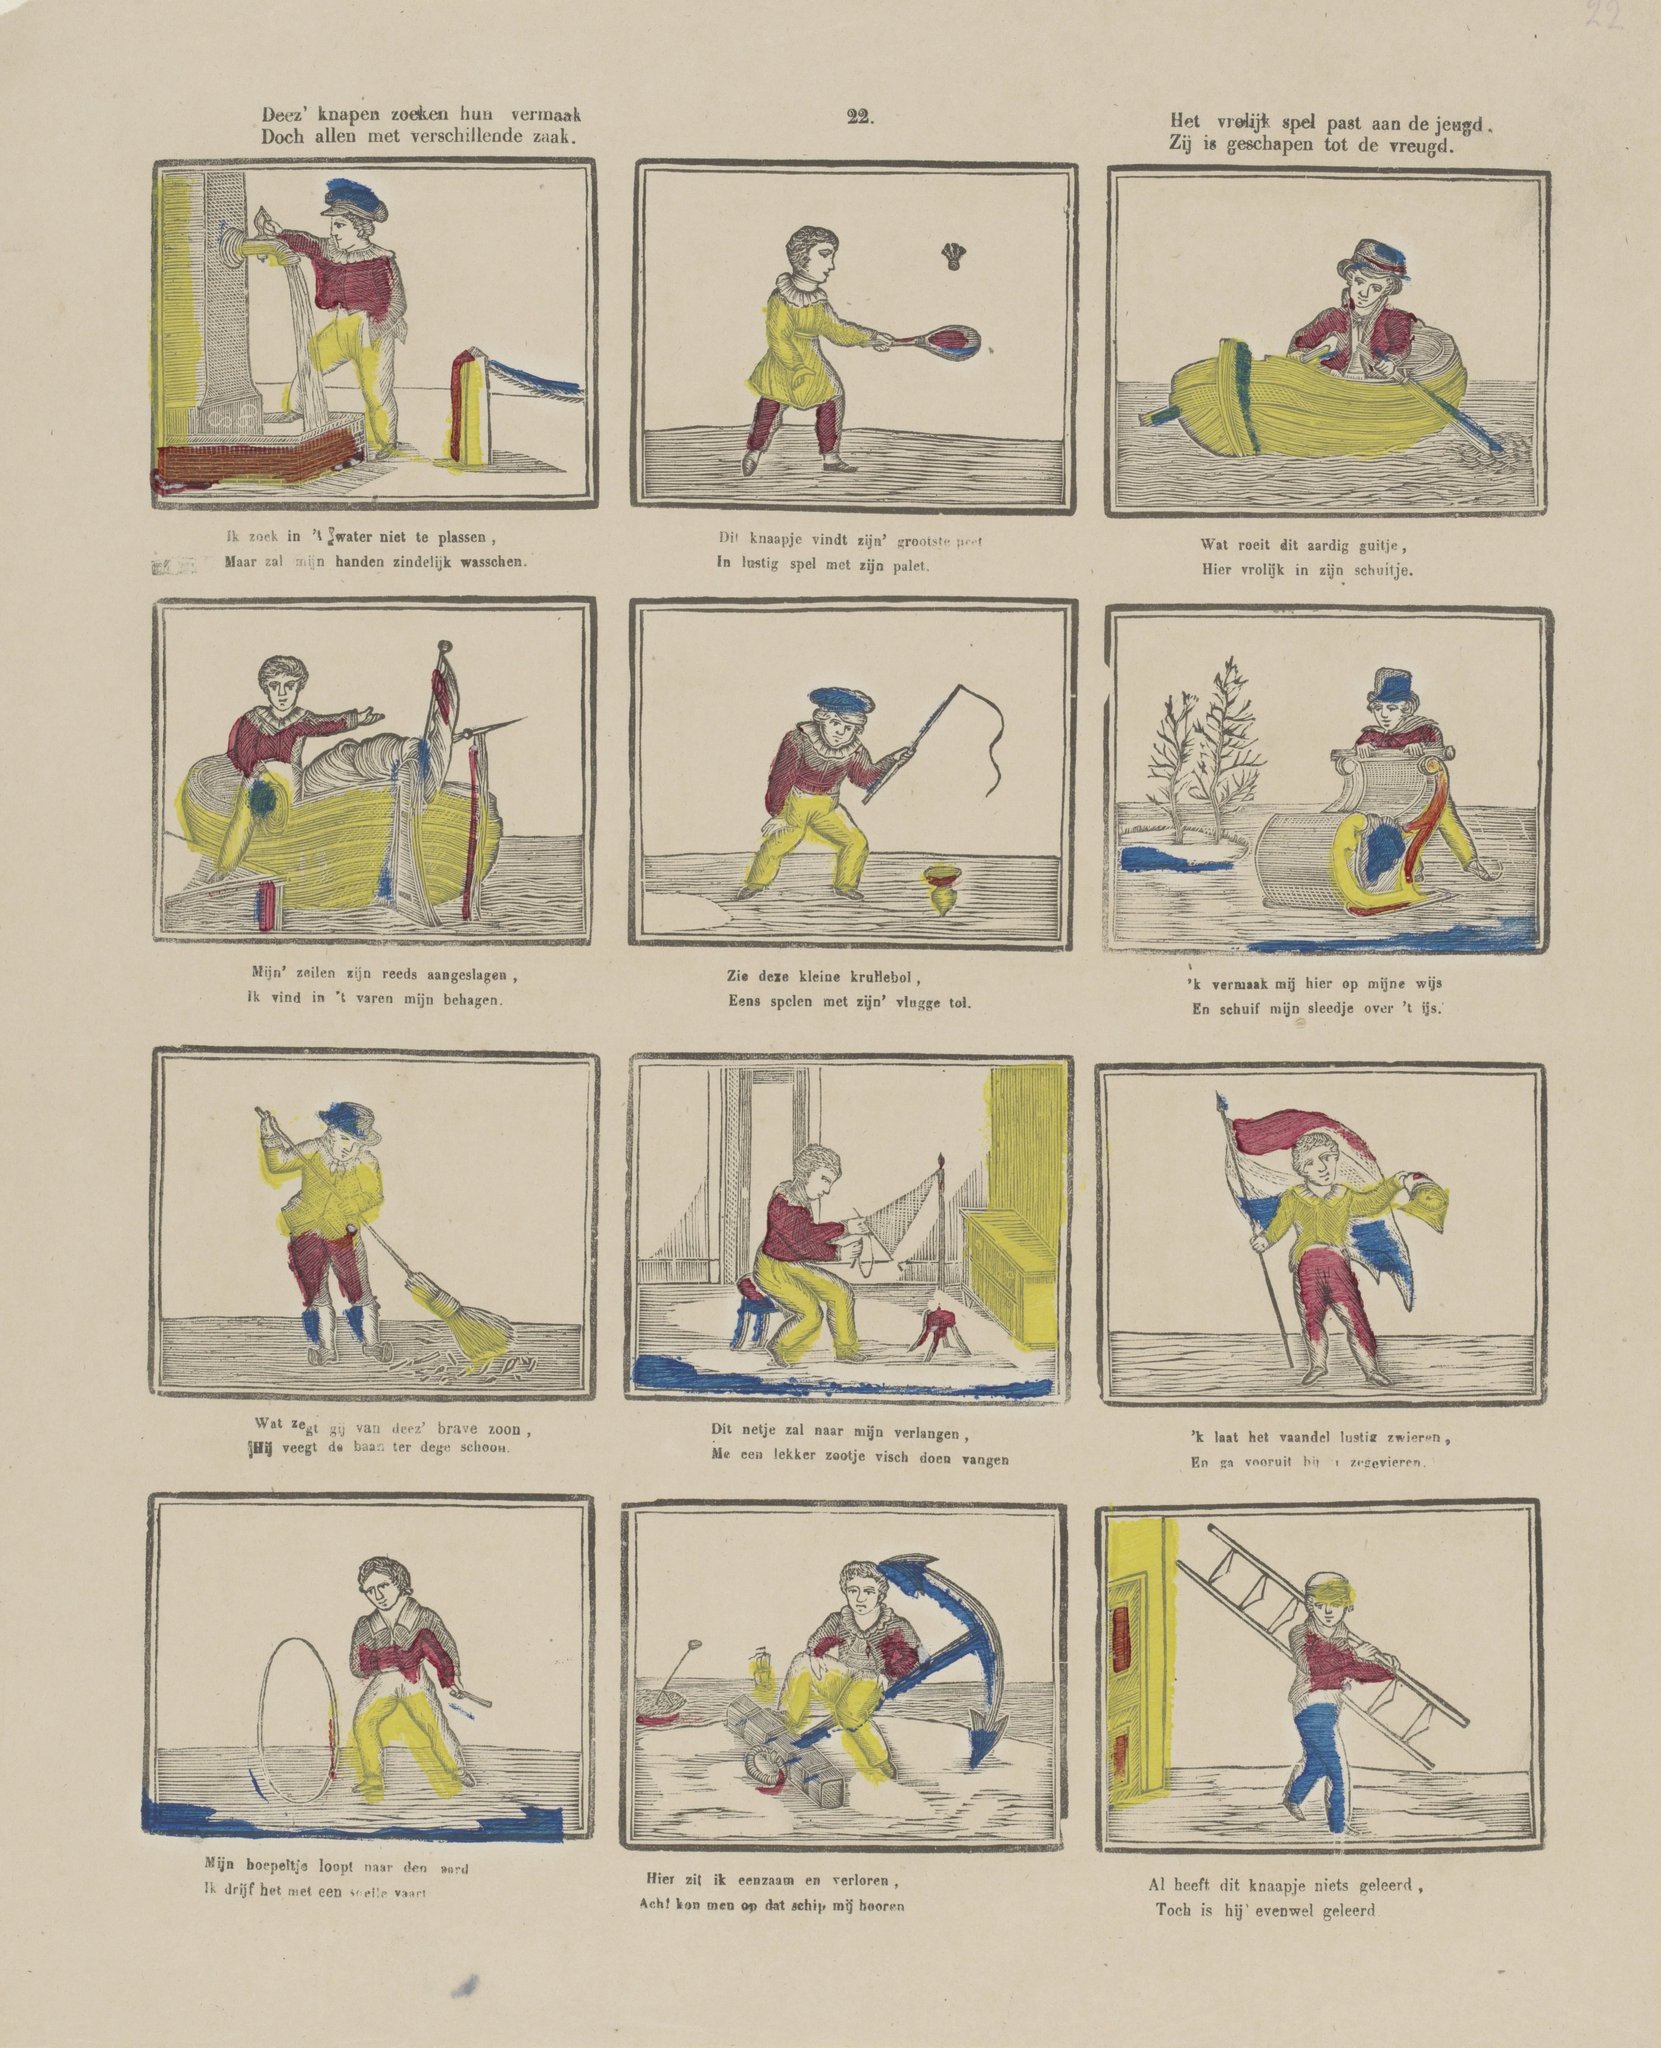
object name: popular print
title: Deez' knapen zoeken hun vermaak / Doch allen met verschillende zaak / Het vrolijk spel past aan de jeugd, / Zij is geschapen tot de vreugd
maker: Anonymous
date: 1848-1881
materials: paper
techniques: colour, letterpress printing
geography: den bosch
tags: children's games and plays, games using special objects (marbles, top, hoop, etc.)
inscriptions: collector's mark: Lugt 2760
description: Blad met 12 voorstellingen van kinderspelen en bezigheden, zoals roeien, tollen en hoepelen. Genummerd midden boven: 22.